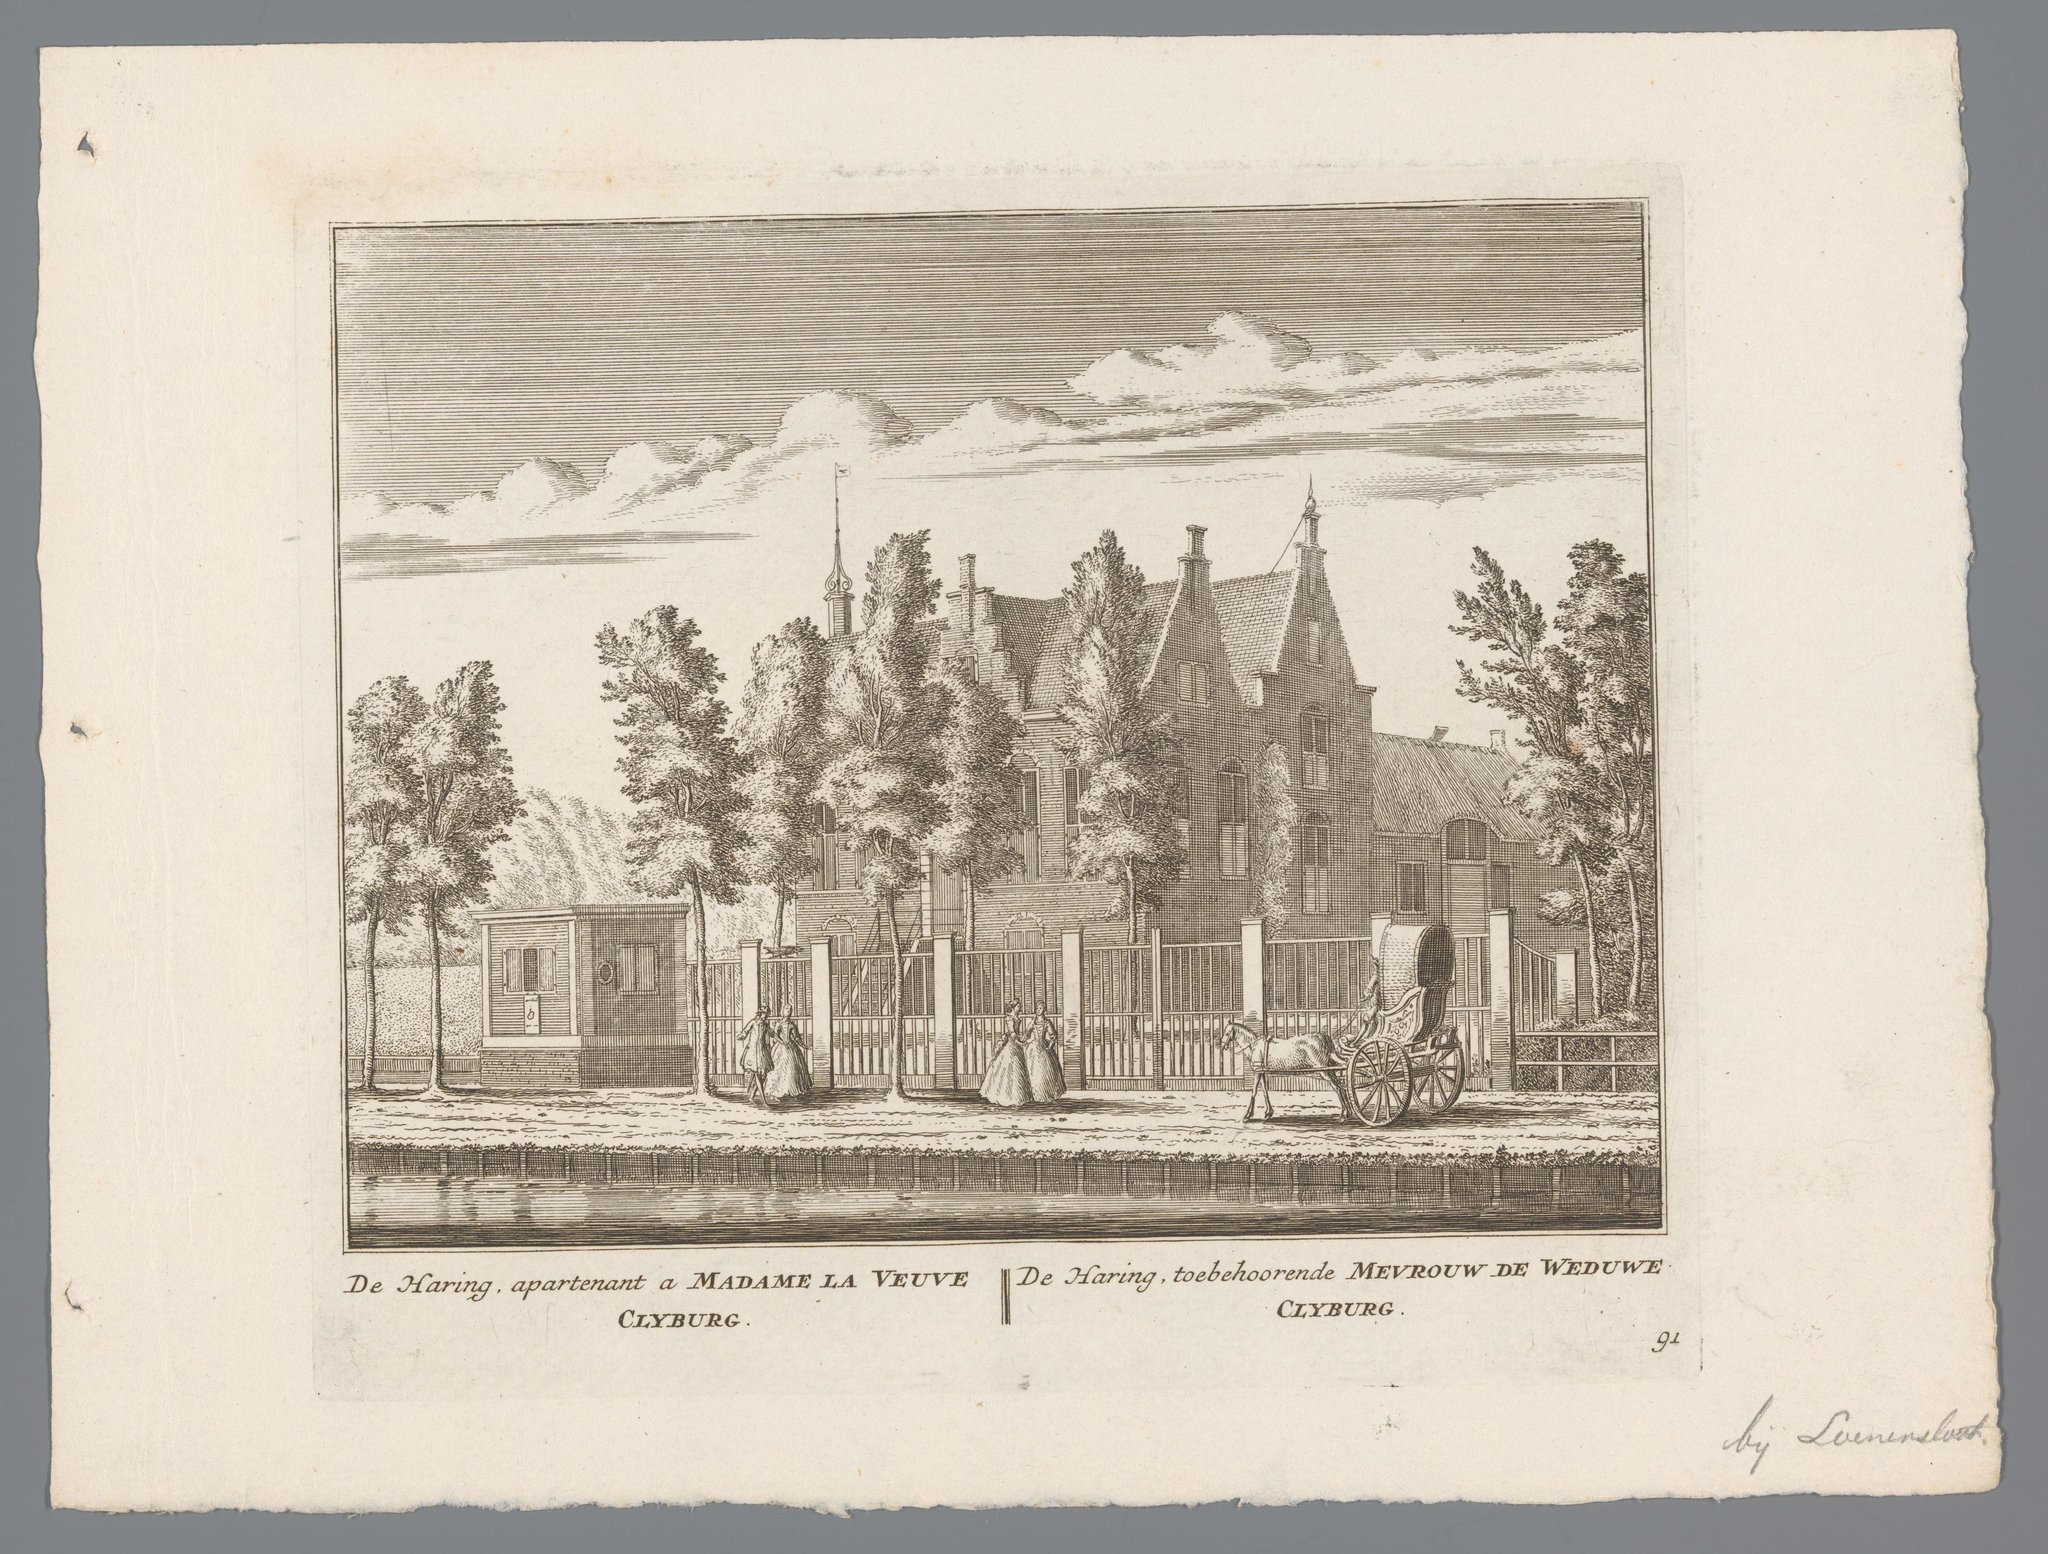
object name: print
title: Gezicht op de buitenplaats de Haring, bij Loenersloot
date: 1730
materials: paper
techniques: etching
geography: amsterdam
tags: rural housing, e.g. country-house, villa, cottage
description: Prent uit: Rademaker, Abraham. Hollands Arcadia, of de vermaarde rivier den Amstel (...) / L'Arcadie Hollandoise (...). Amsterdam: Leonard Schenk, 1730.